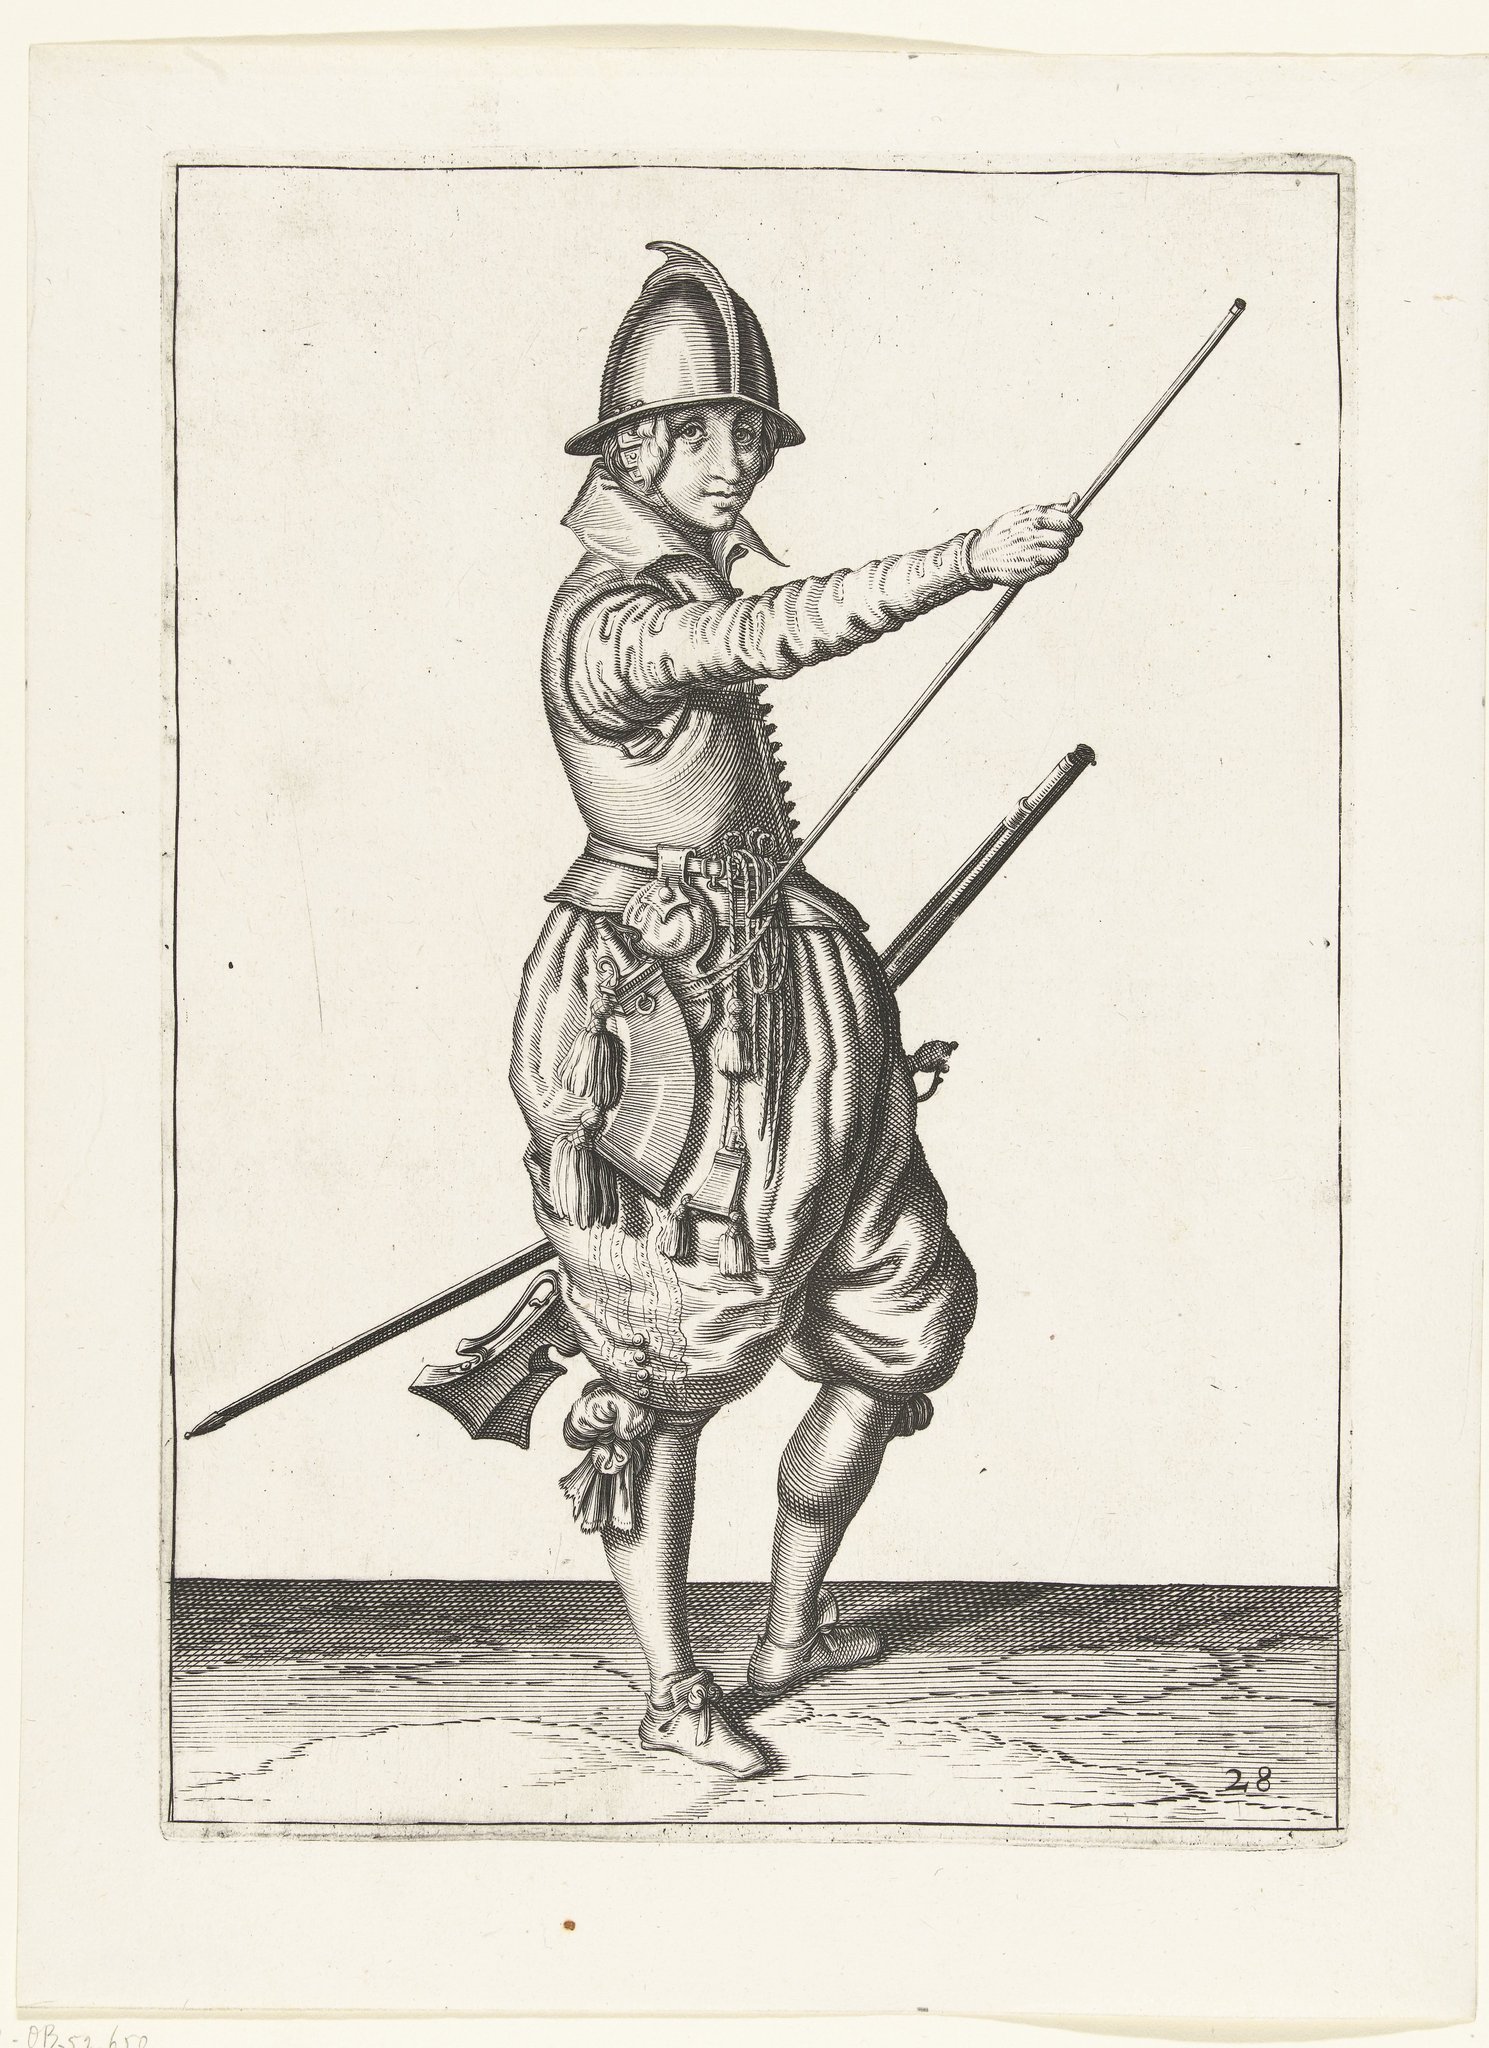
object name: print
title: Wapenhandelinghe van Roers Musquetten ende Spiessen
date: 1597-1607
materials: paper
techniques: engraving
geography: netherlands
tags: manoeuvre ~ military training, firearms: rifle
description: Een soldaat, ten voeten uit, naar rechts, die met zijn linkerhand bij zijn linkerdijbeen een roer (een bepaald type vuurwapen) vasthoudt en zijn rechterhand naar het uiteinde brengt van zijn laadstok, die hij tegen zijn rechterzij laat steunen. Deze prent is onderdeel van de reeks van 42 genummerde prenten van roerschutters uit de Wapenhandelinghe.